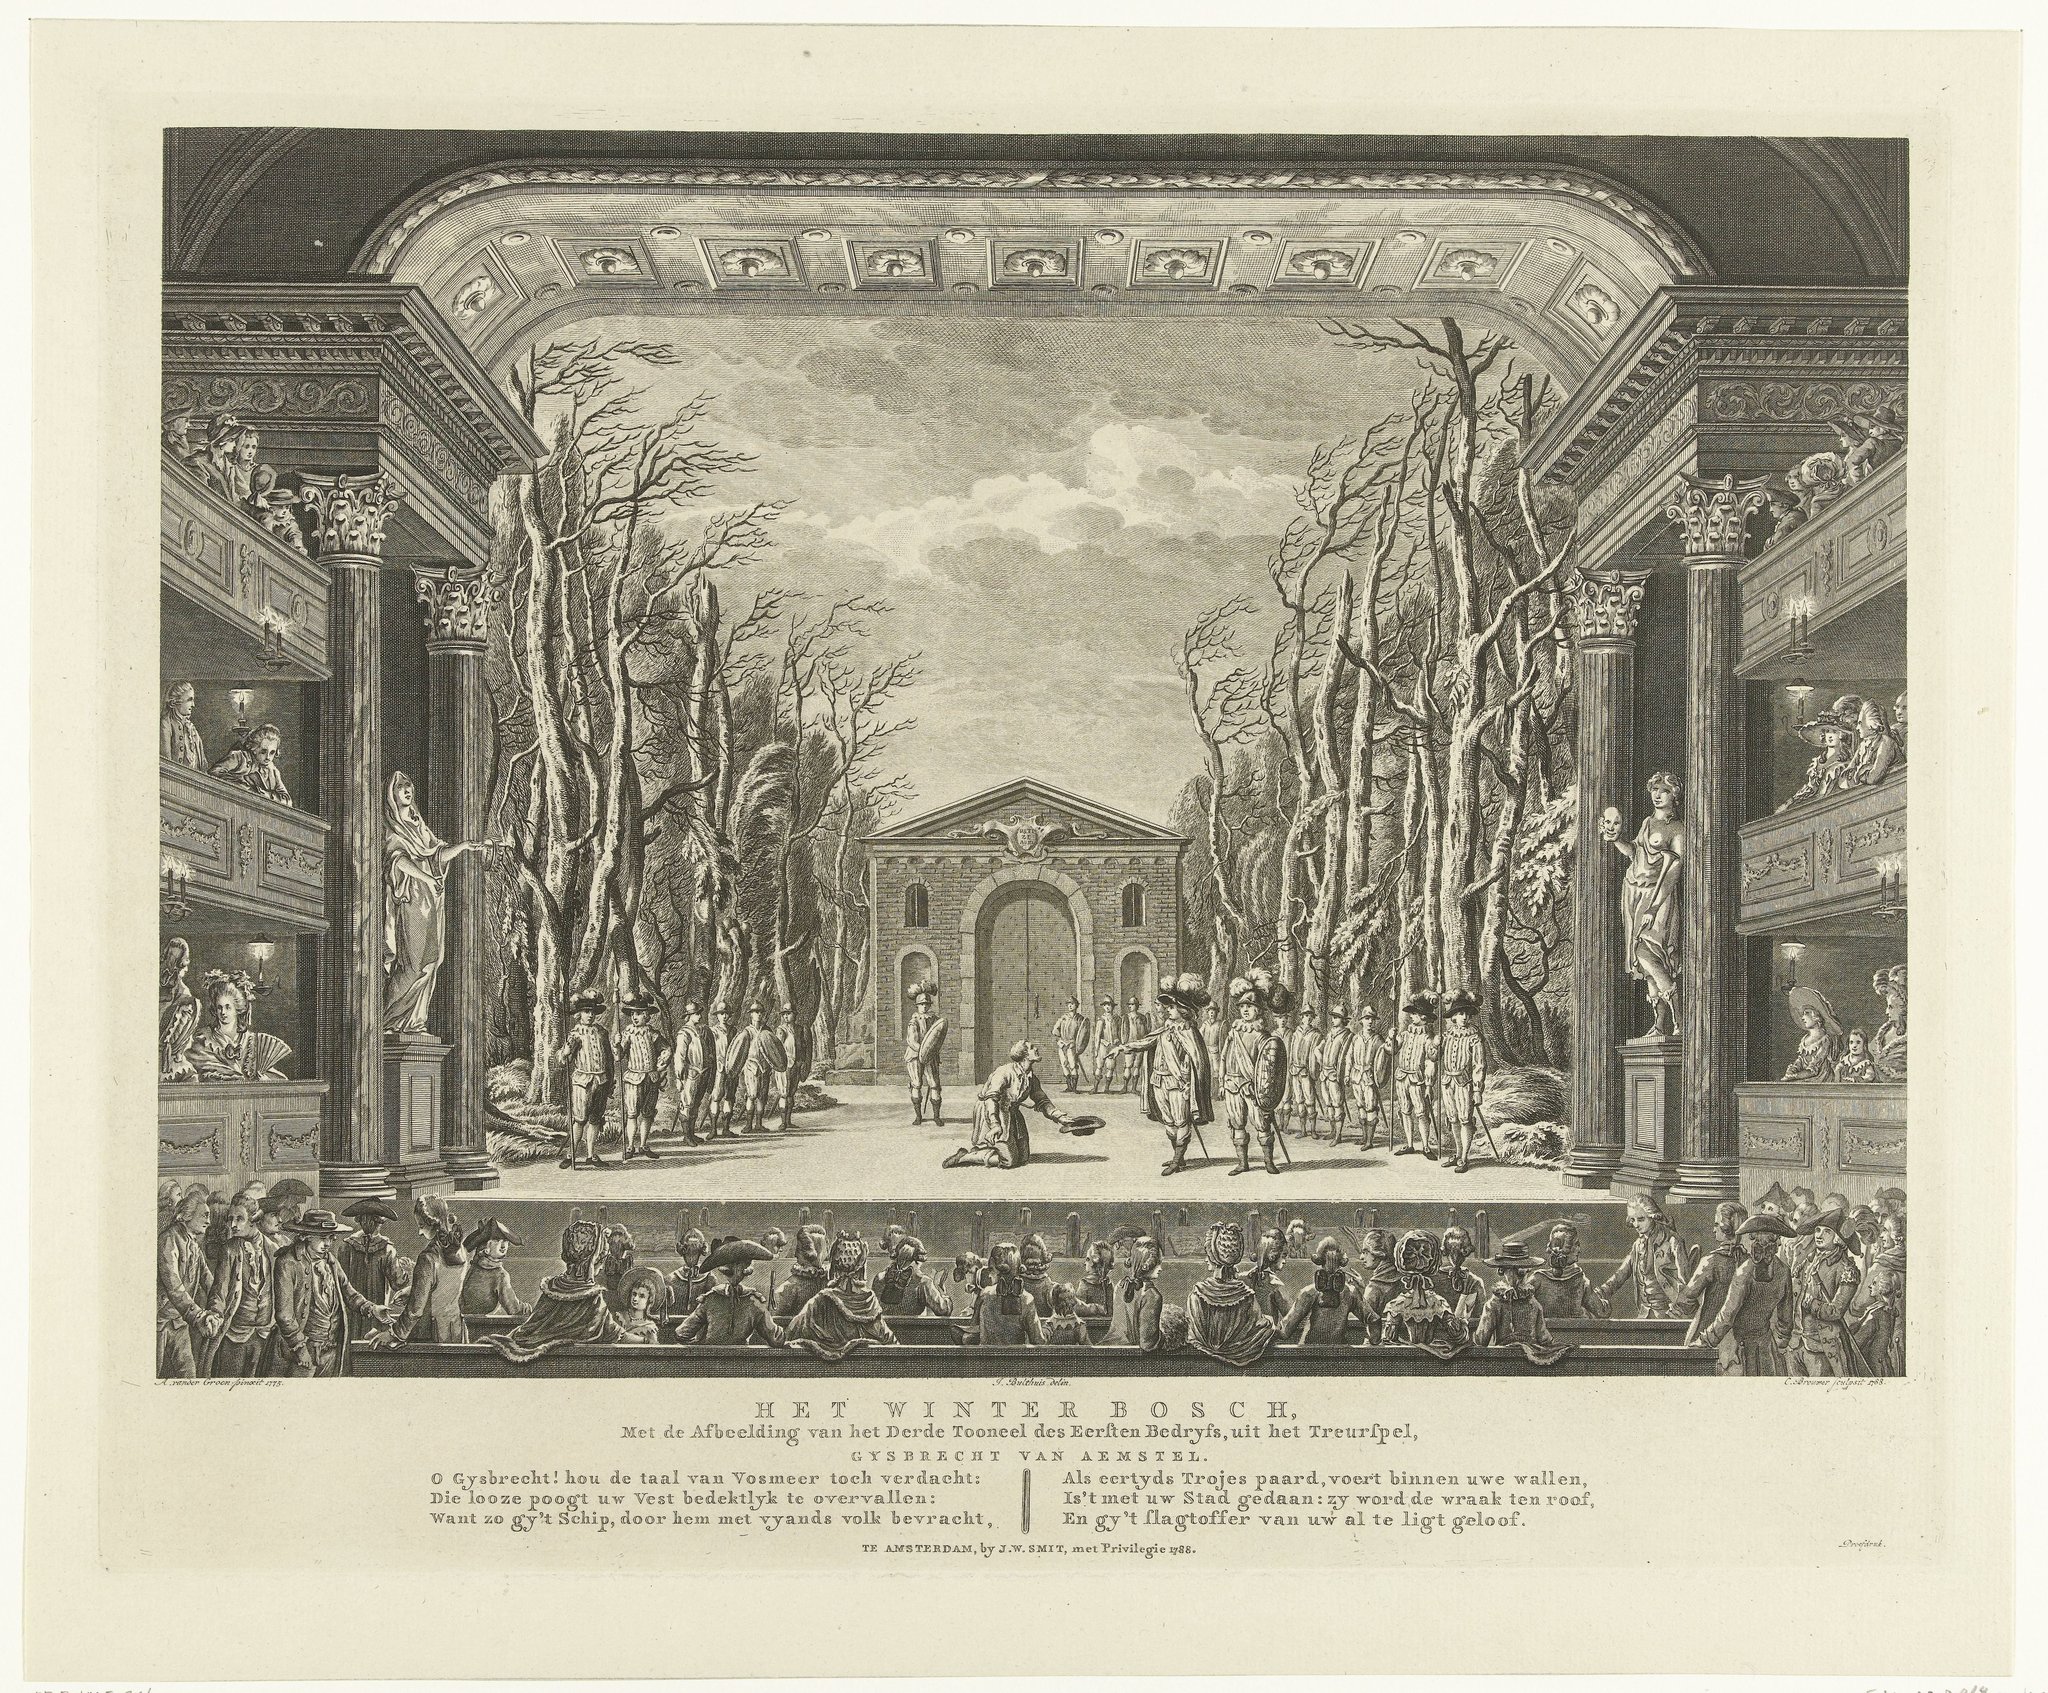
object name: print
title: Decor met het winterbos in de Nieuwe Schouwburg te Amsterdam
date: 1788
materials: paper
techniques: engraving, etching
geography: amsterdam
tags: theatre, theatrical performance, theatre (building)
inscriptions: collector's mark: Lugt 2228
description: Prent naar tekening van Jan Bulthuis. Bulthuis baseerde zich op een schilderij van A. van der Groen, gedateerd 1775.